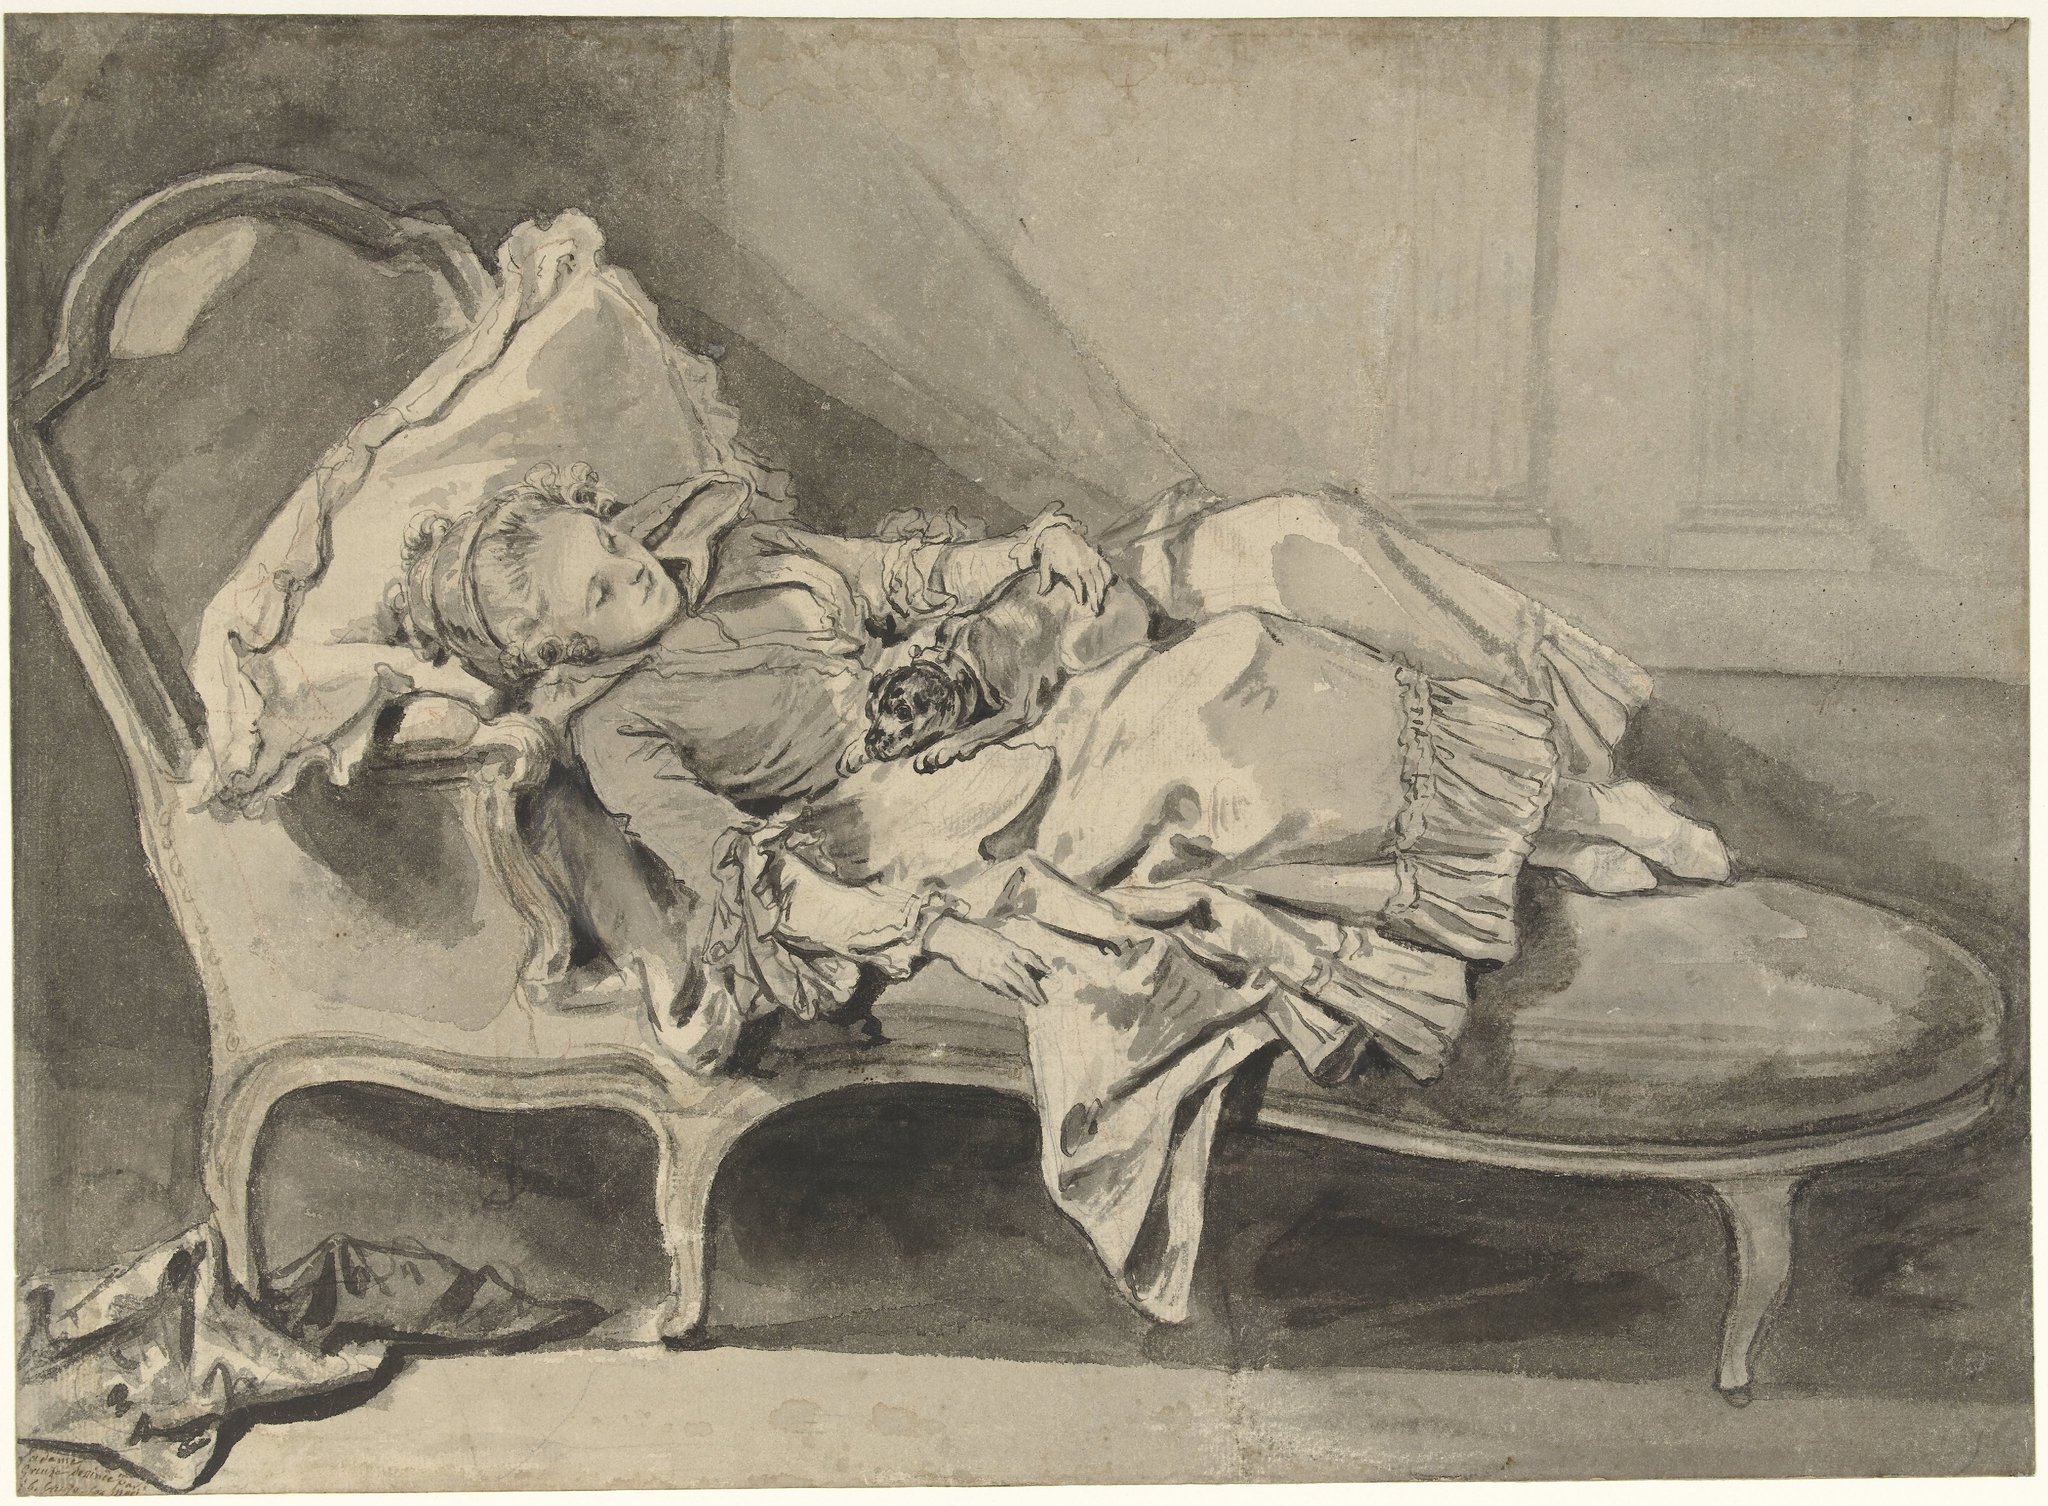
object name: drawing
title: Madame Greuze op een chaise-longue met haar hondje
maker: jean-baptiste greuze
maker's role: painter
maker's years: 1725-1805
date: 1757-1760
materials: chalk, graphite, ink, paper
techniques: brush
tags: resting